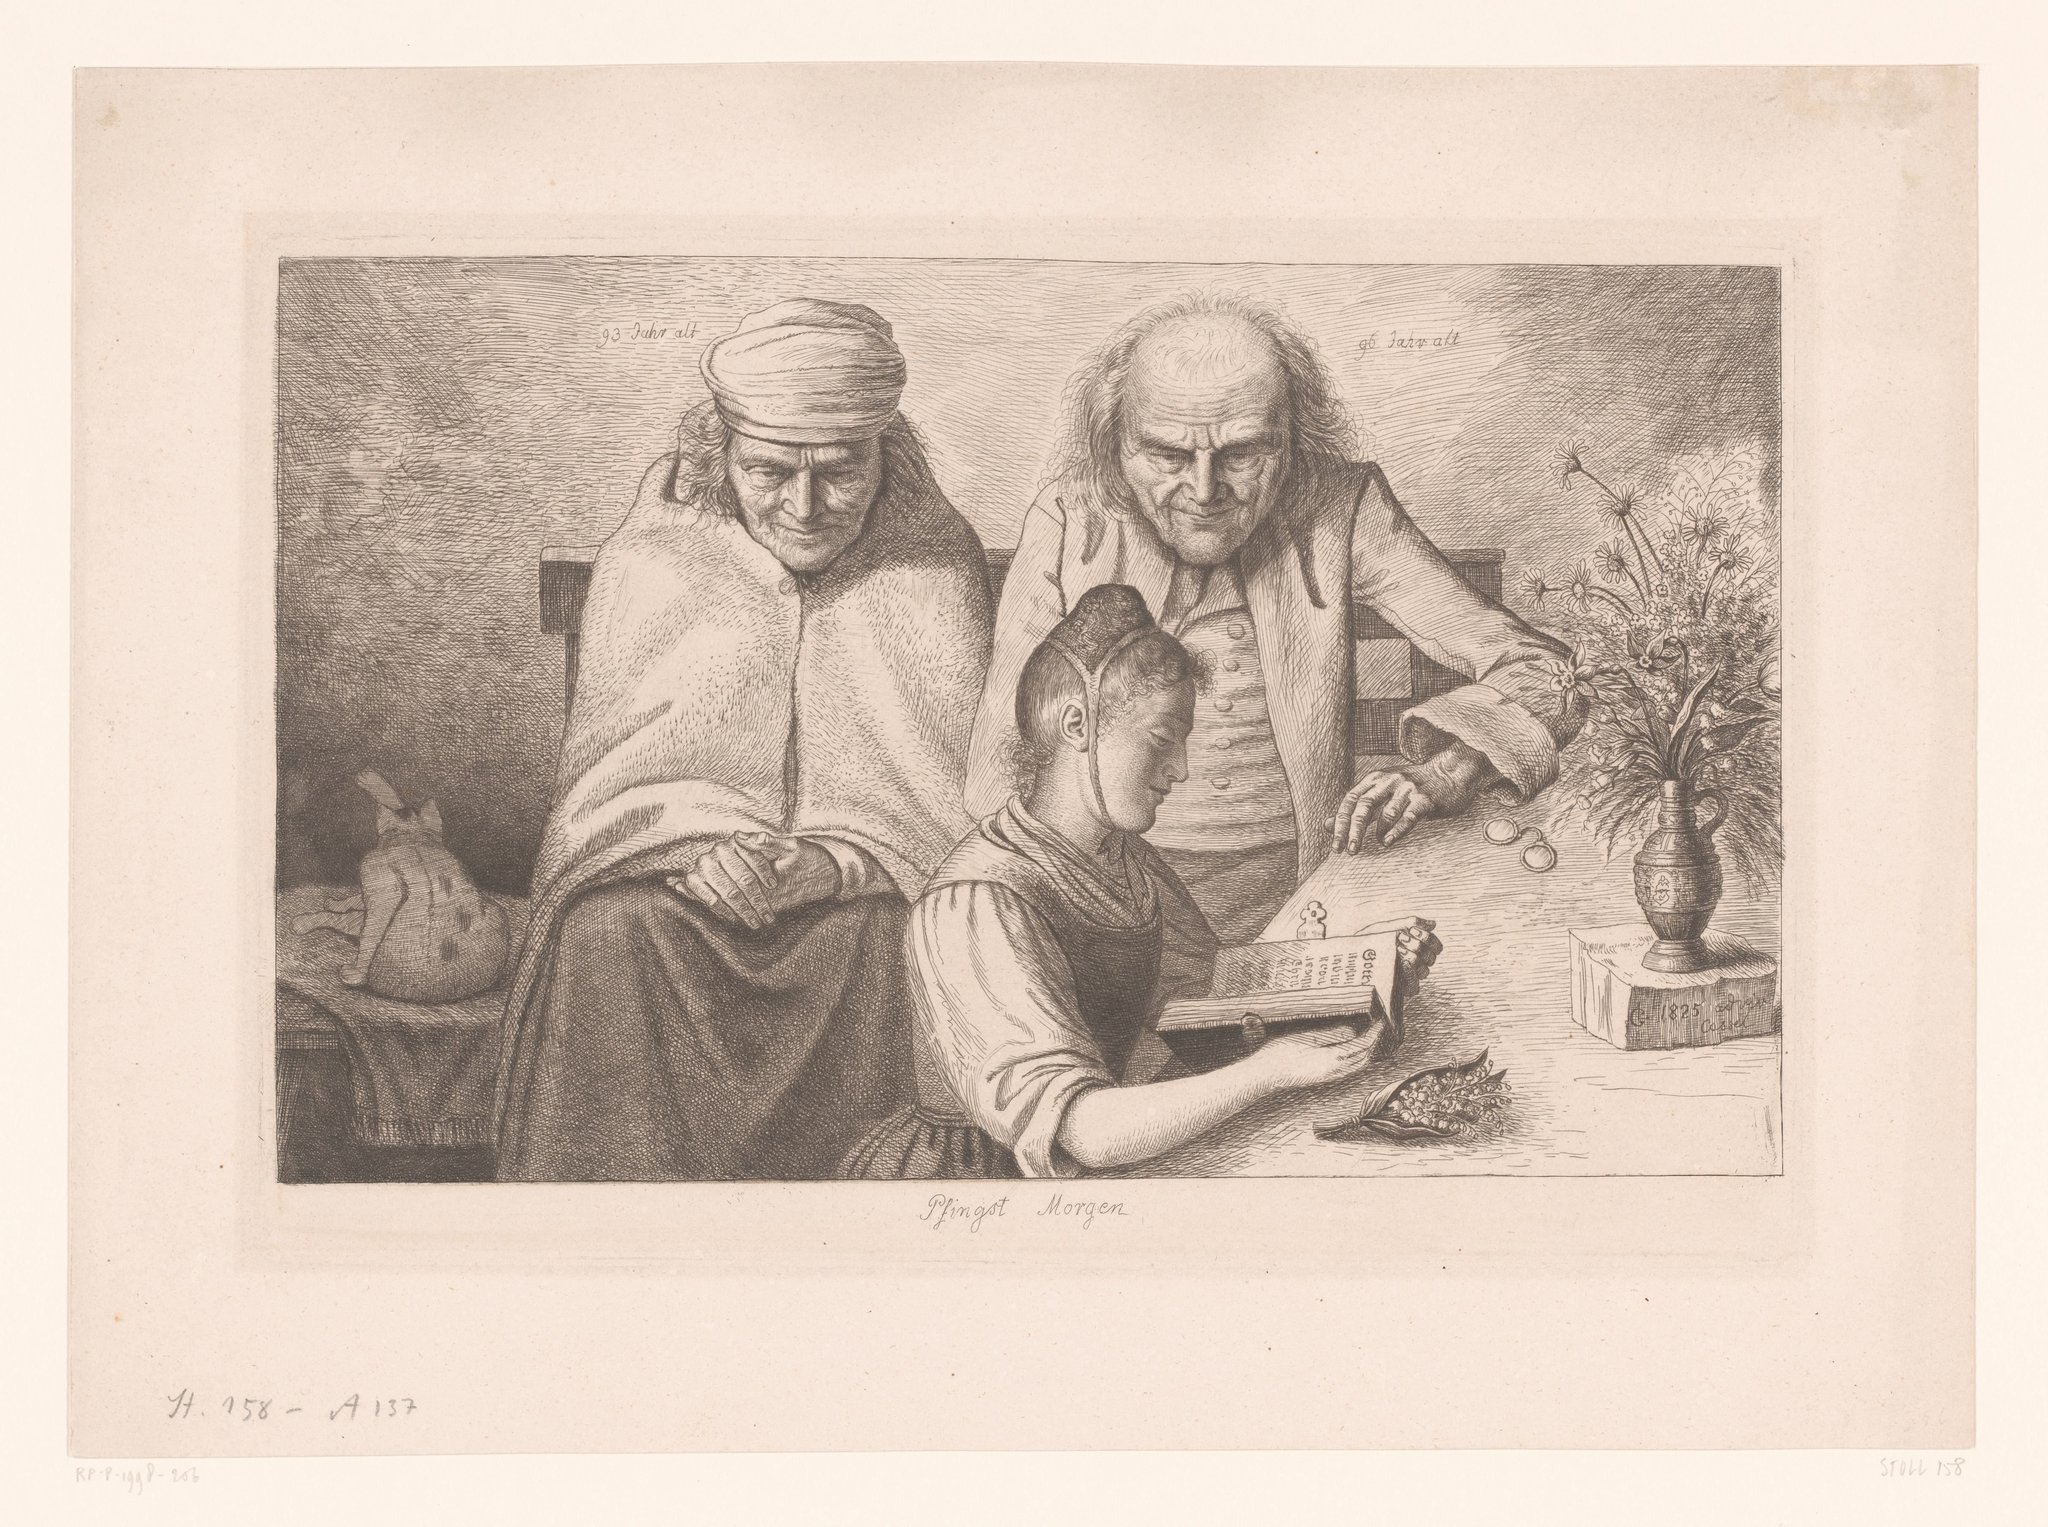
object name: print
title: Pinkstermorgen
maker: ludwig emil grimm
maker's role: print maker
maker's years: 1790-1863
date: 1825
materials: paper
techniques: etching, intaglio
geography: kassel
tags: cut flowers; nosegay, bunch of flowers, reading, cat, girl (child between toddler and youth), old man, old woman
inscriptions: collector's mark: Lugt 2228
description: Een 93-jarige vrouw en een 96-jarige man op een bank. Voor hen aan tafel leest een meisje uit een boek.